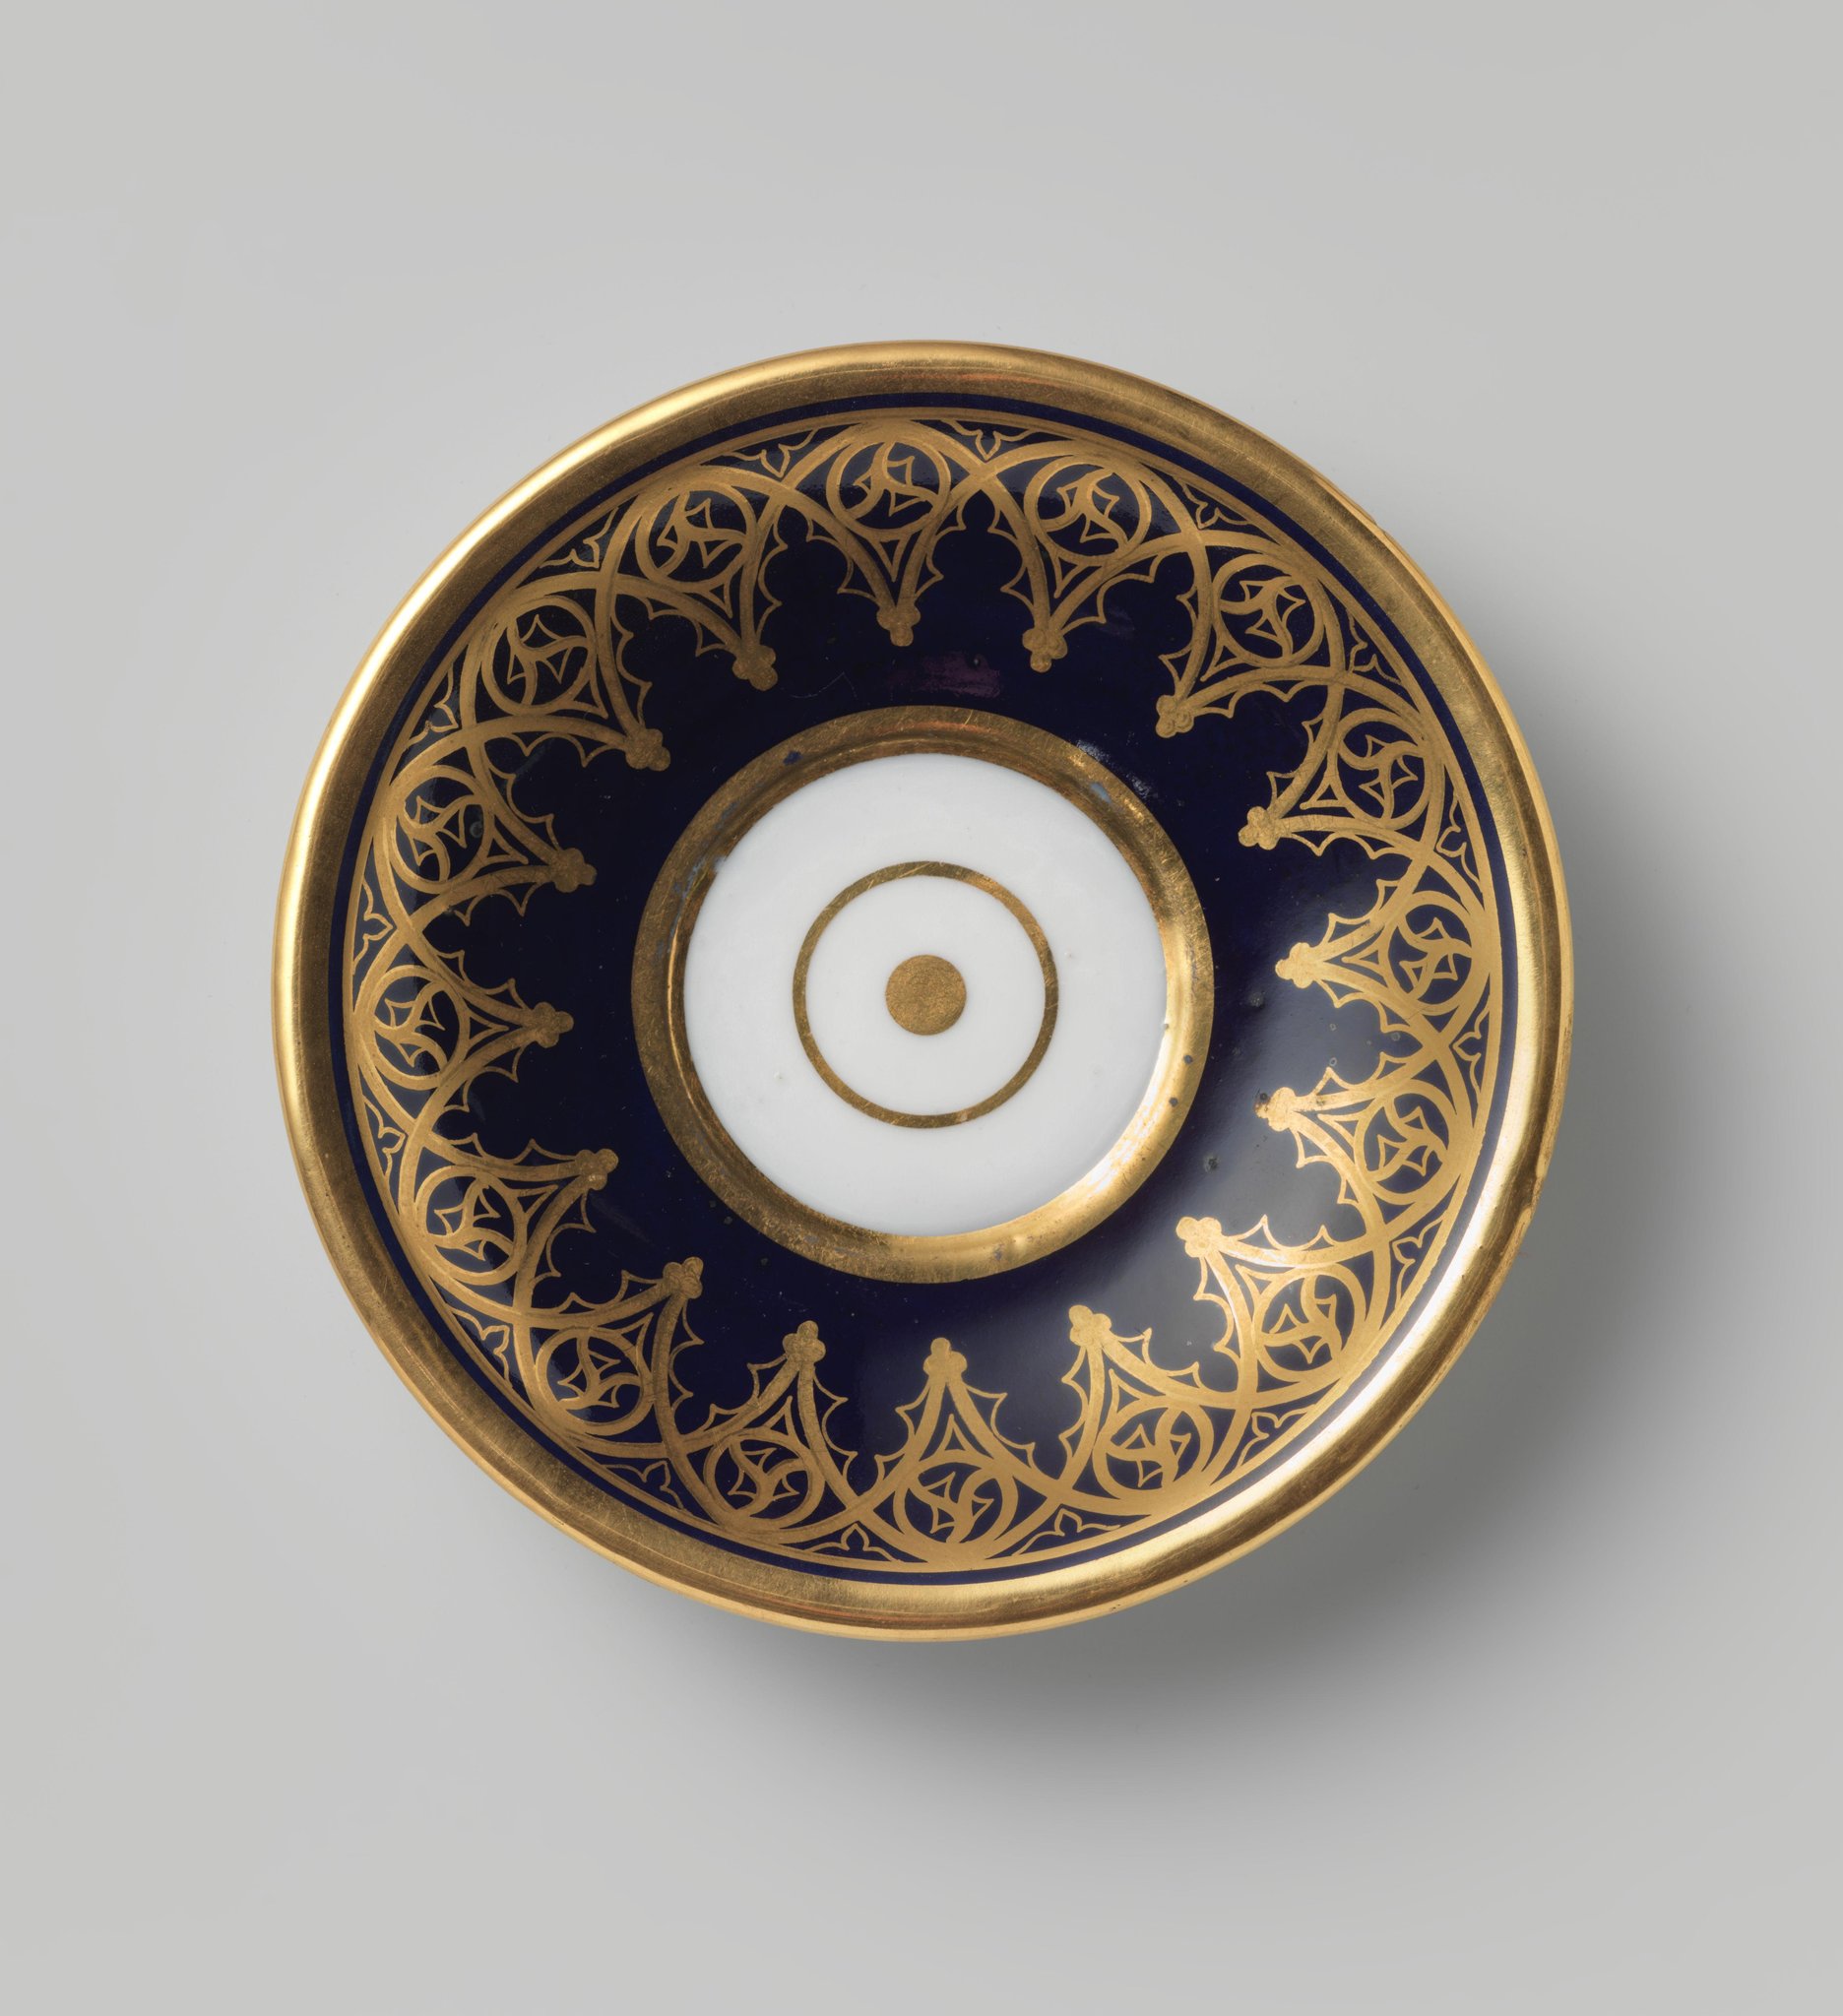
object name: platter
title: Saucer with a gothic arcade decoration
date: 1800-1899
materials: cobalt, glaze, gold, paint, porcelain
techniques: firing, forming, gilding, turning, vitrification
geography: saint-yrieix-la-perche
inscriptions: mark: ‘vis’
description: Schotel van porselein, deel van servies, beschilderd in goud op een koningsblauw fond met een arcademotief met gotische traceringen. Buiten dit decor en voor een groot deel aan de binnenzijde verguld. Gemerkt met een groen visje. Opmerking: zie voor merken ook het algemeen record.